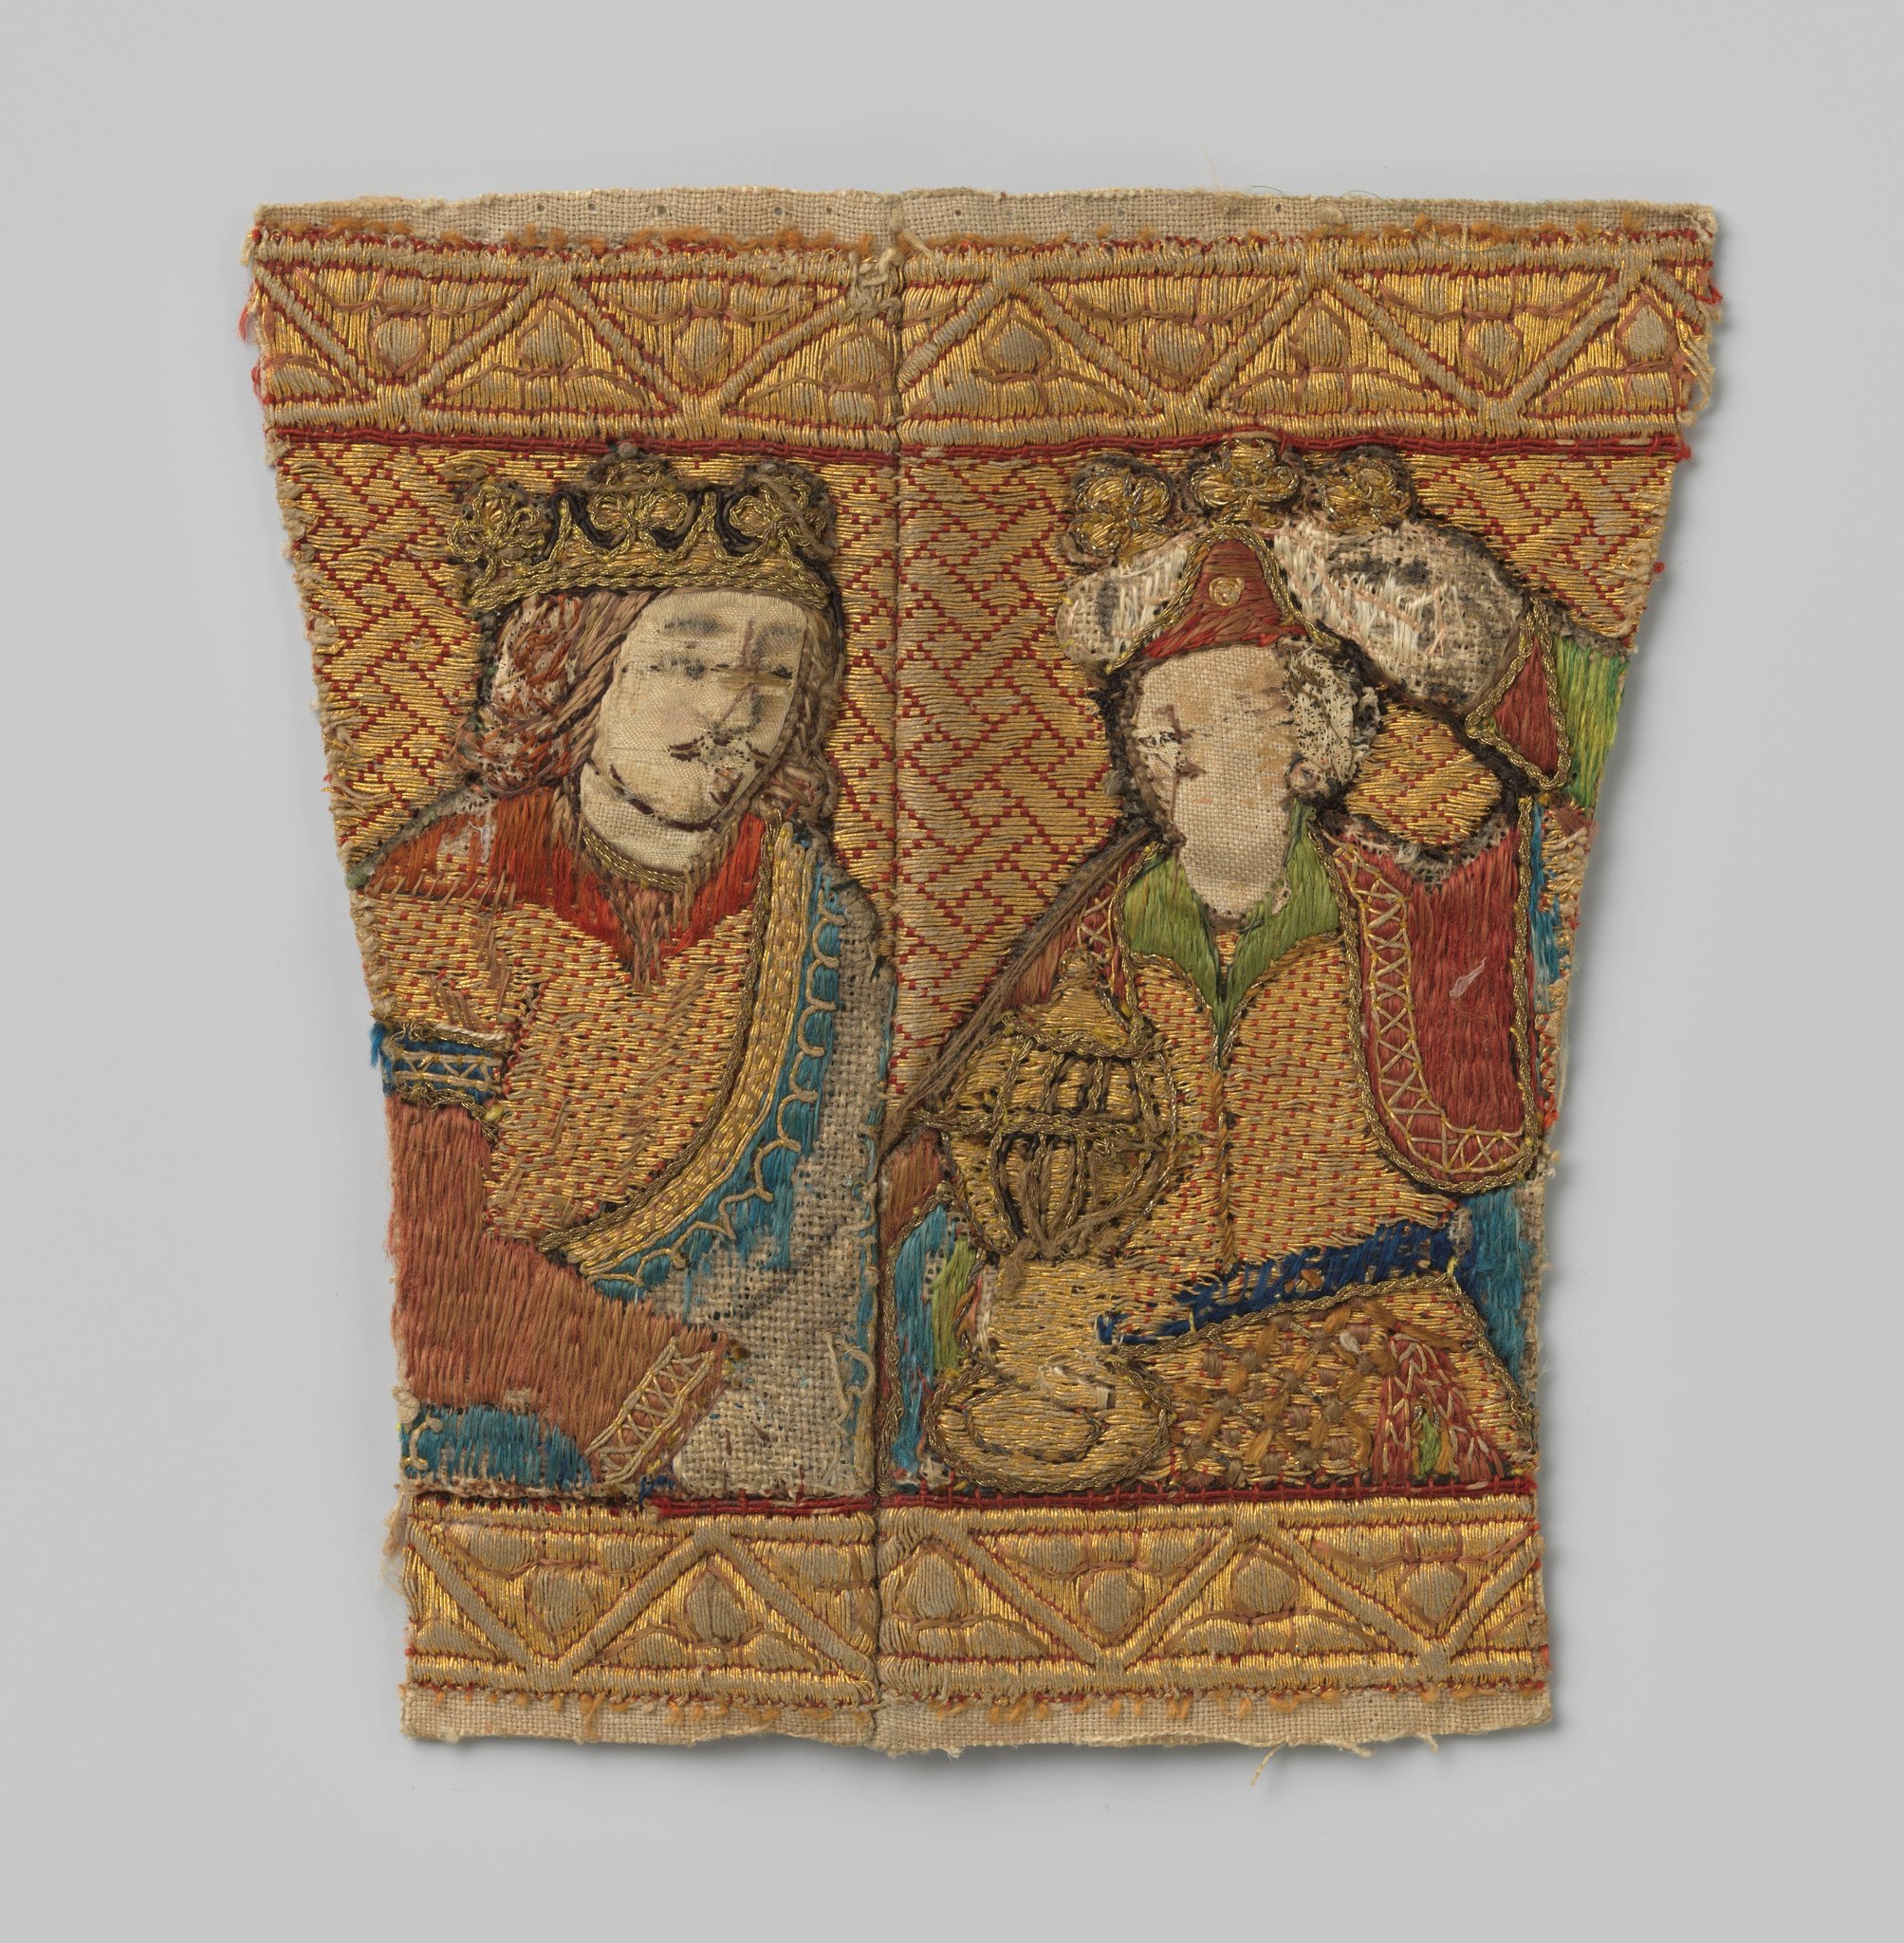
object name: strip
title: Fragment van een strook borduurwerk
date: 1400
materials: textile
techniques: embroidered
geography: germany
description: Fragment van een strook borduurwerk. Het borduurwerk heeft een afbeelding van de aanbidding van de koningen. Bij het fragment hoort een fragment met invnr. BK-NM-3609-B.